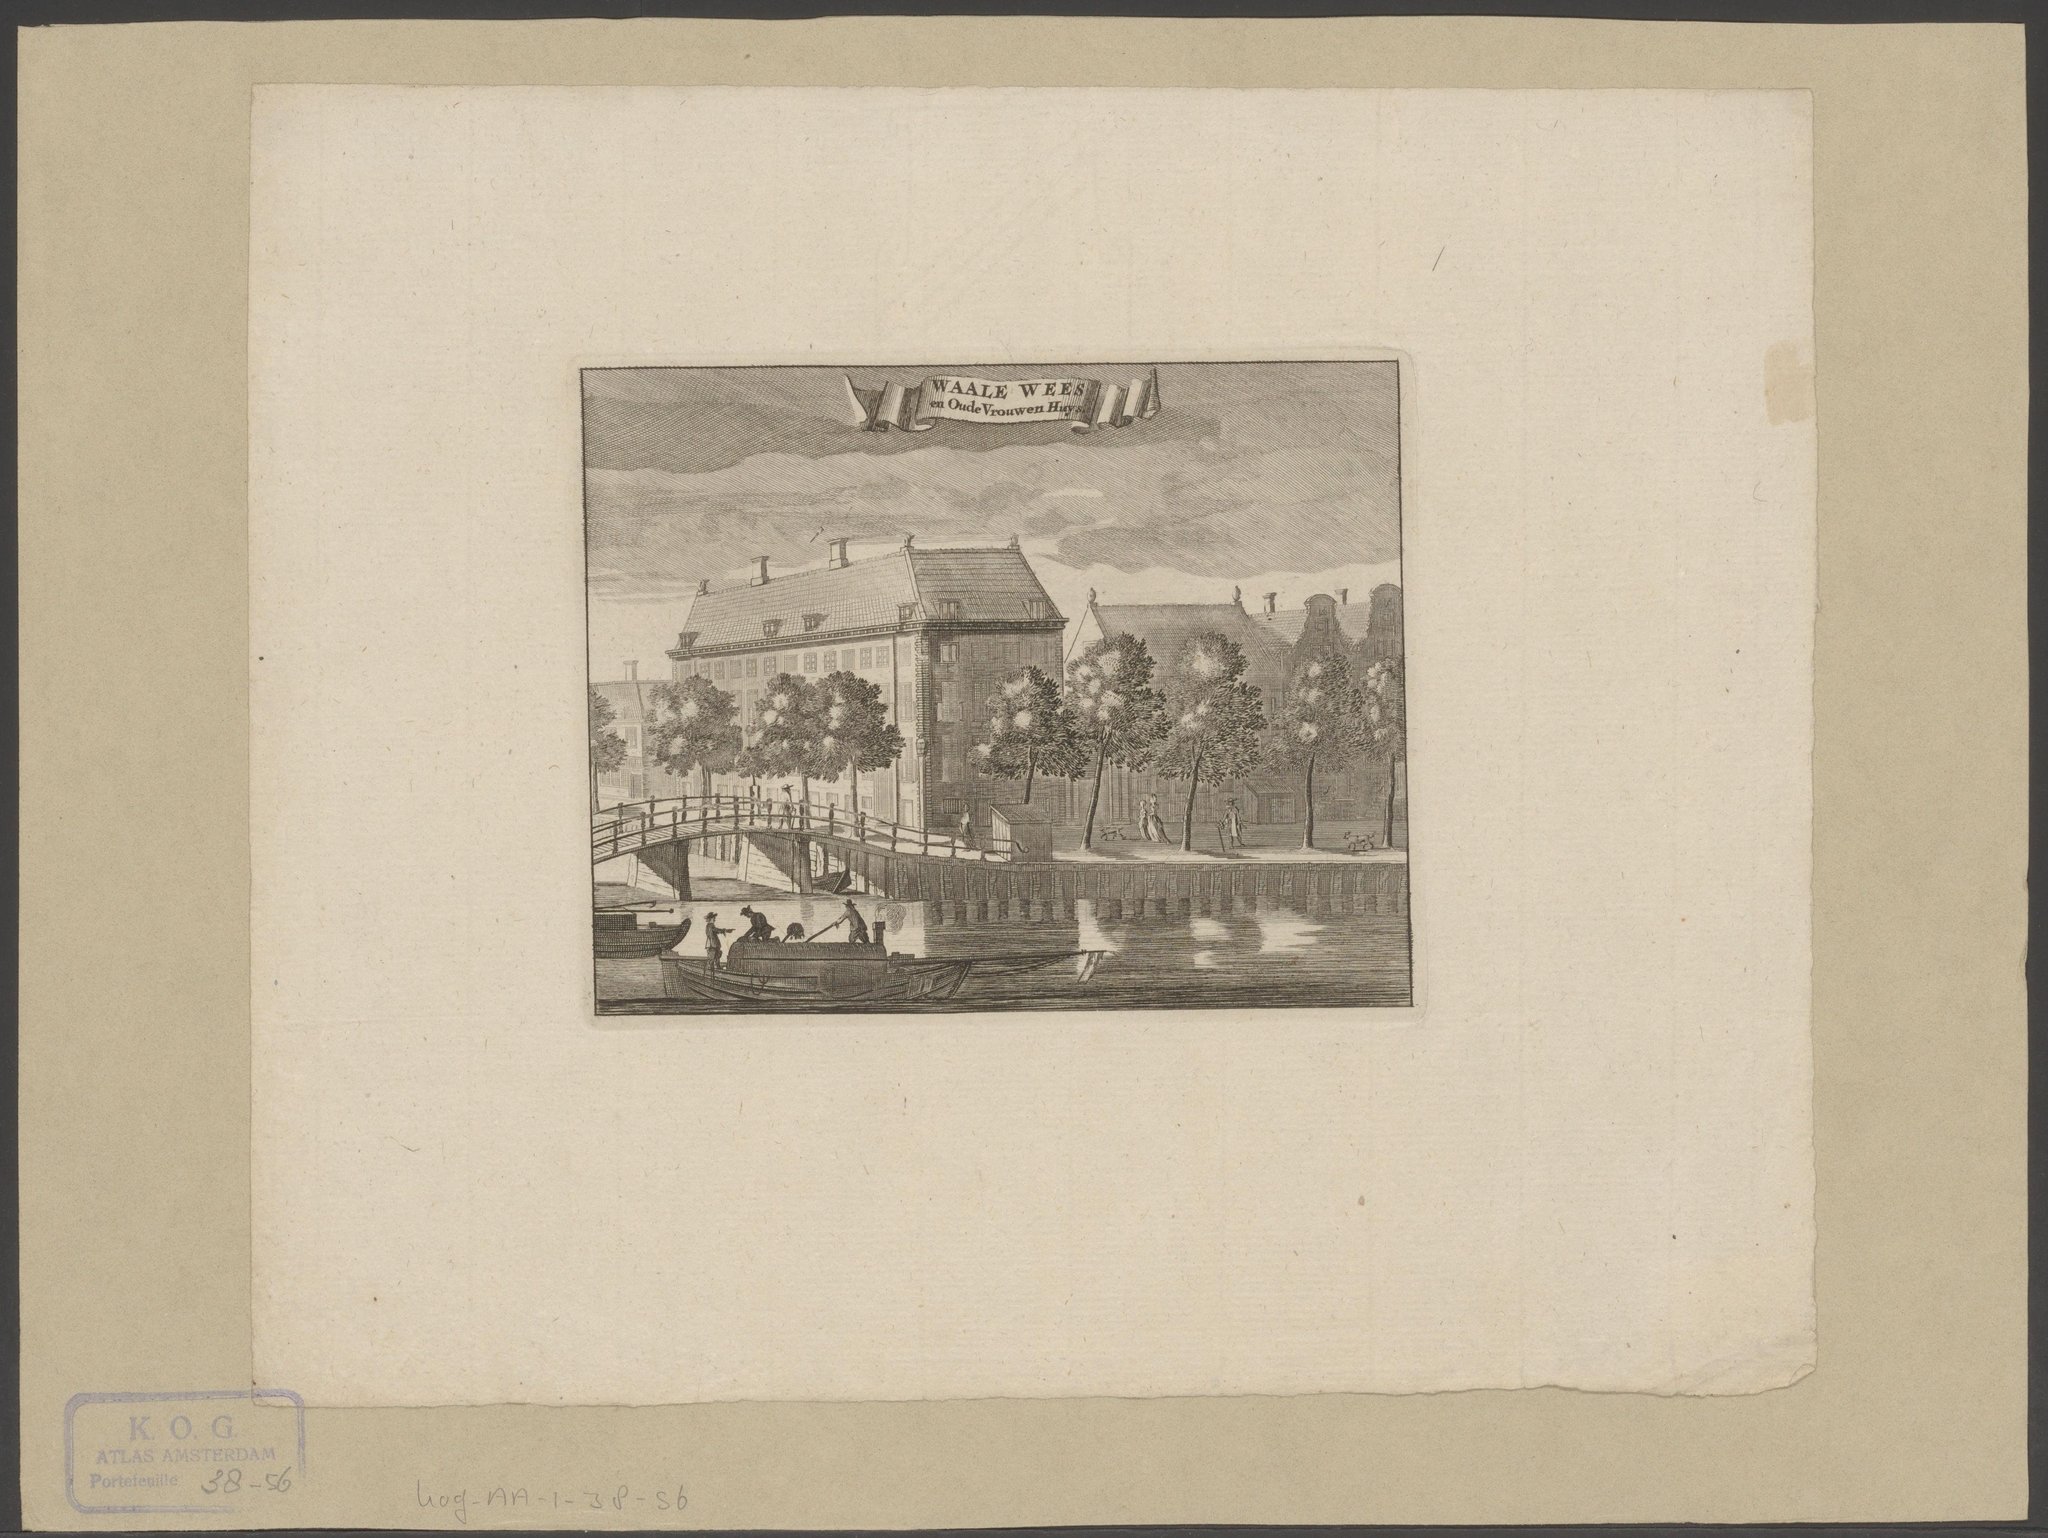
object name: print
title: Gezicht op het Walenweeshuis aan de Vijzelgracht te Amsterdam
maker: Anonymous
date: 1726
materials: paper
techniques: engraving, etching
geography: northern netherlands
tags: bridge in city across river, canal, etc. (+ city(-scape) with figures, staffage), rowing-boat, canoe, etc., orphanage, canals, waters (in city) (+ city(-scape) with figures, staffage)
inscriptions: collector's mark: Lugt 1641b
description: Huidige staat van prent ook gebruikt in: Commelin, Casparus. Beschryvinge van Amsterdam (…). 2de druk. Amsterdam: Andries van Damme, Johannes Ratelband, weduwe Antony van Aeltwijk en Hermanus Uytwerf, 1726, dl. 2, p. 605. Eerste staat van prent (zonder opgewerkte lucht- en waterpartijen) ook gebruikt in: Commelin, Casparus. Beschryvinge van Amsterdam (…). Amsterdam: Abraham Wolfgang, Gillis Janssonius van Waesberge of Johannes Janssonius van Waesberge, Hendrick Boom of weduwe Dirk Boom, Abraham van Sanderen en Rembertus Goethals, 1693, dl. 2, p. 605. En in: Commelin, Casparus. Beschryvinge van Amsterdam (…). Amsterdam: weduwe Aart Dircksz. Oossaan, 1694, dl. 2, p. 605.